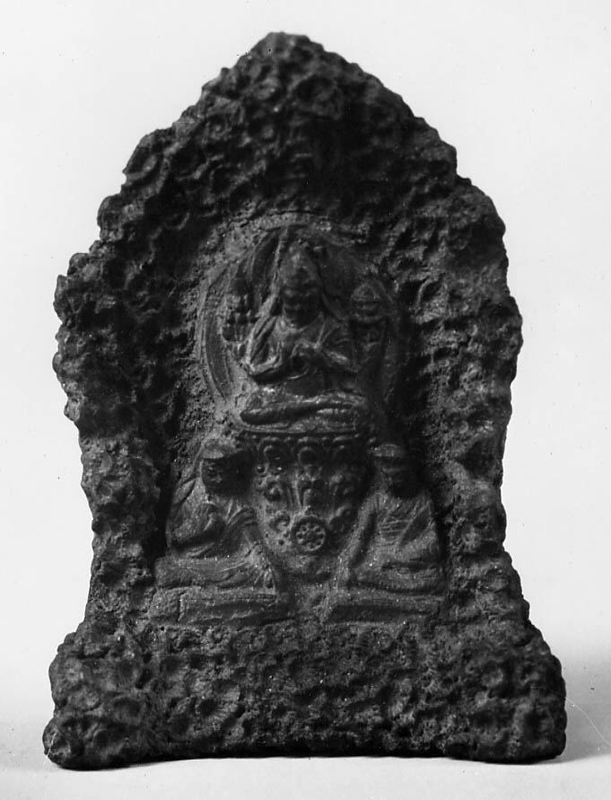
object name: votive plaque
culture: tibetan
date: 701-800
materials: clay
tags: human figures